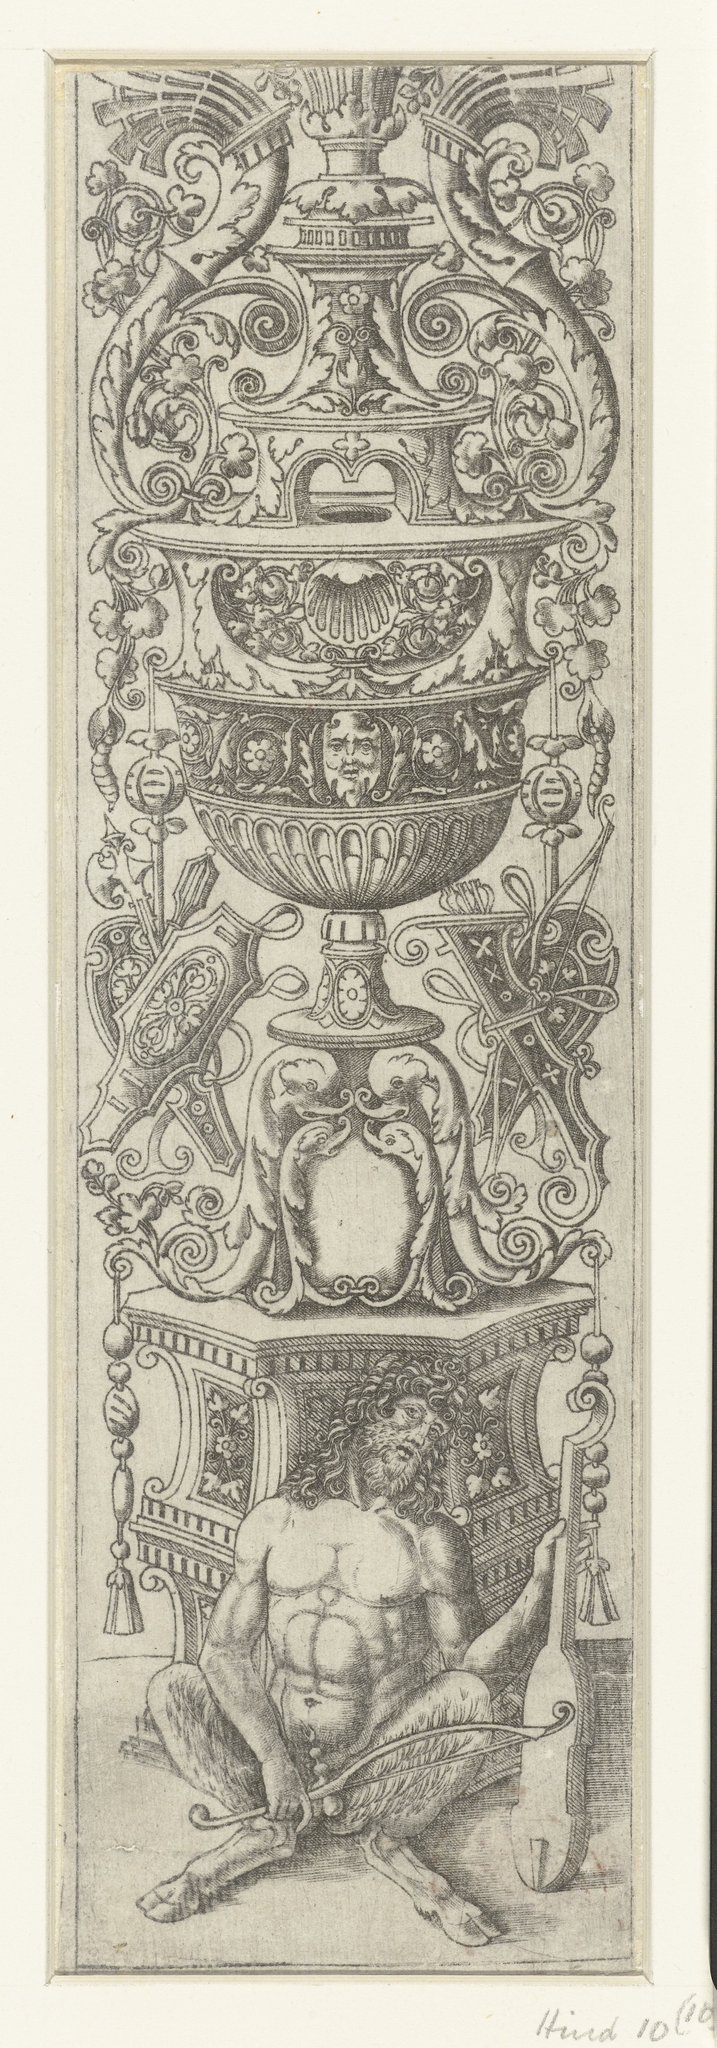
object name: ornament print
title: Ornament panelen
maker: giampietrino birago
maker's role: print maker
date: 1500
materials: paper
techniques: engraving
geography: italy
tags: trophy ~ battle, war, satyr(s) (in general)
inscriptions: collector's mark: Lugt 240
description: Prent maakt deel uit van een serie met twaalf ornament panelen.